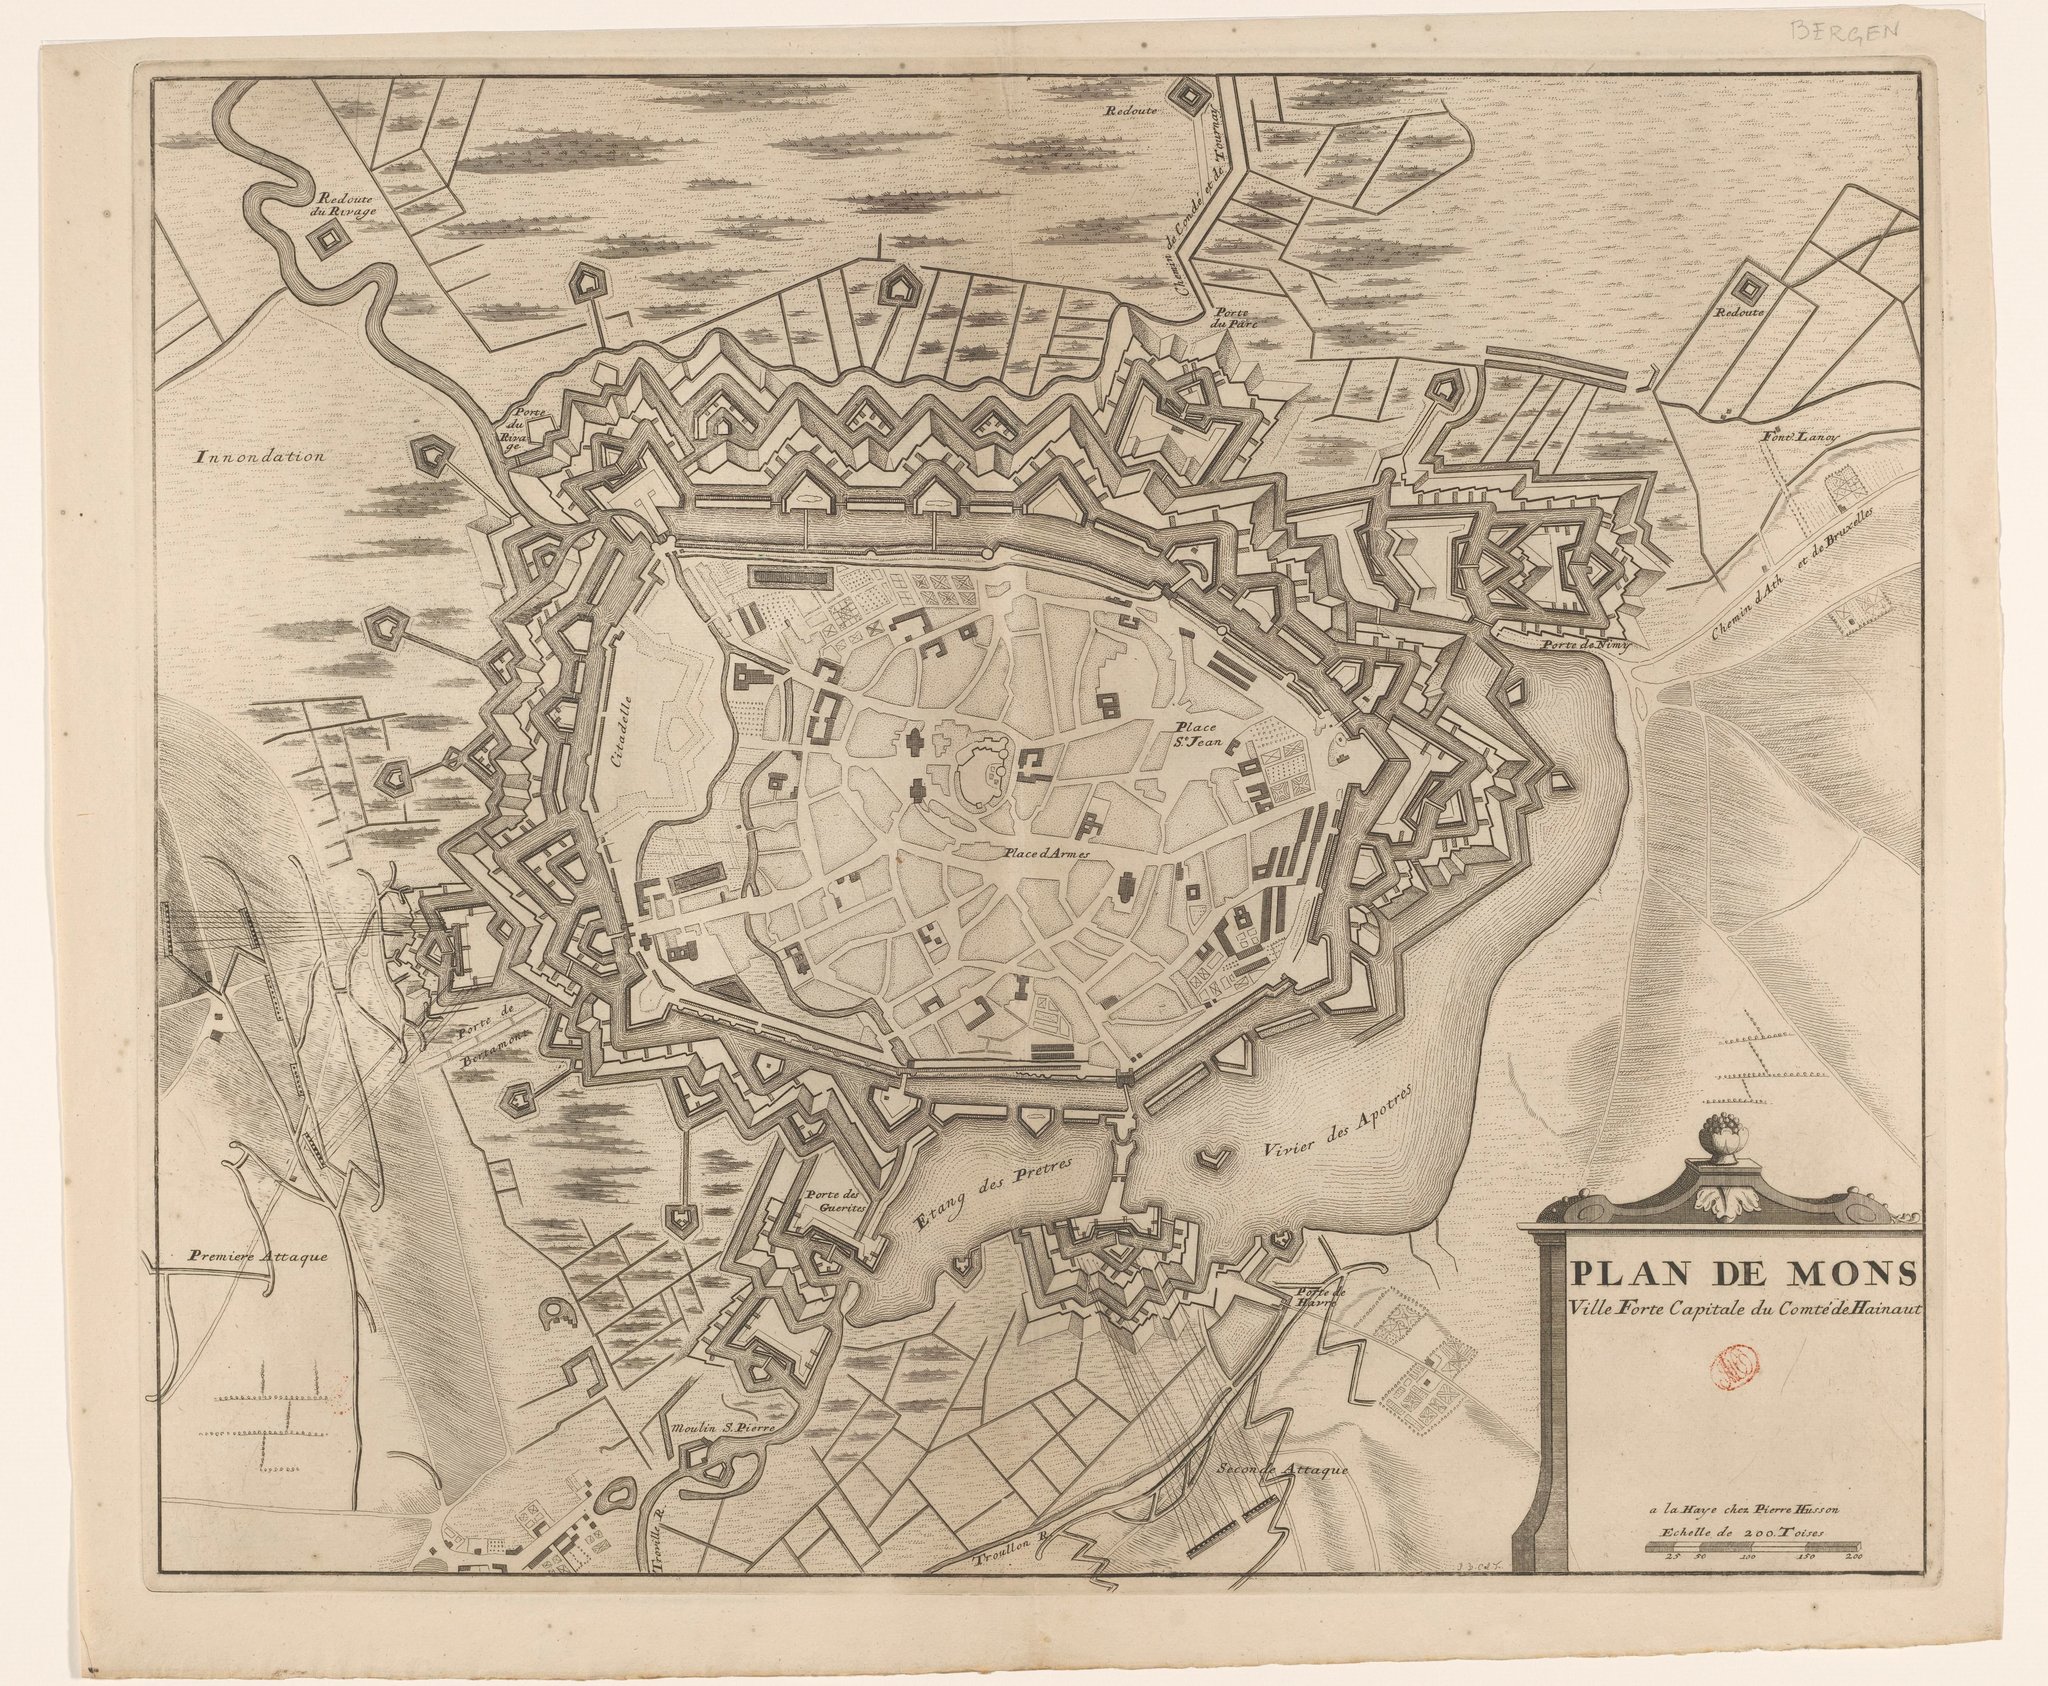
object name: area plan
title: Plan van het beleg van Bergen (Mons), 1709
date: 1709-1732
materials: paper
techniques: etching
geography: northern netherlands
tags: johan willem friso (prins van oranje-nassau), siege, position war, maps of cities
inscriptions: collector's mark: Lugt 195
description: Kaart van het beleg van Bergen (Mons) in Henegouwen door de Geallieerden onder de prins van Oranje vanaf 25 september 1709. Rechtsonder de titelcartouche met onderin een schaalstok: Echelle de 200 Toises.